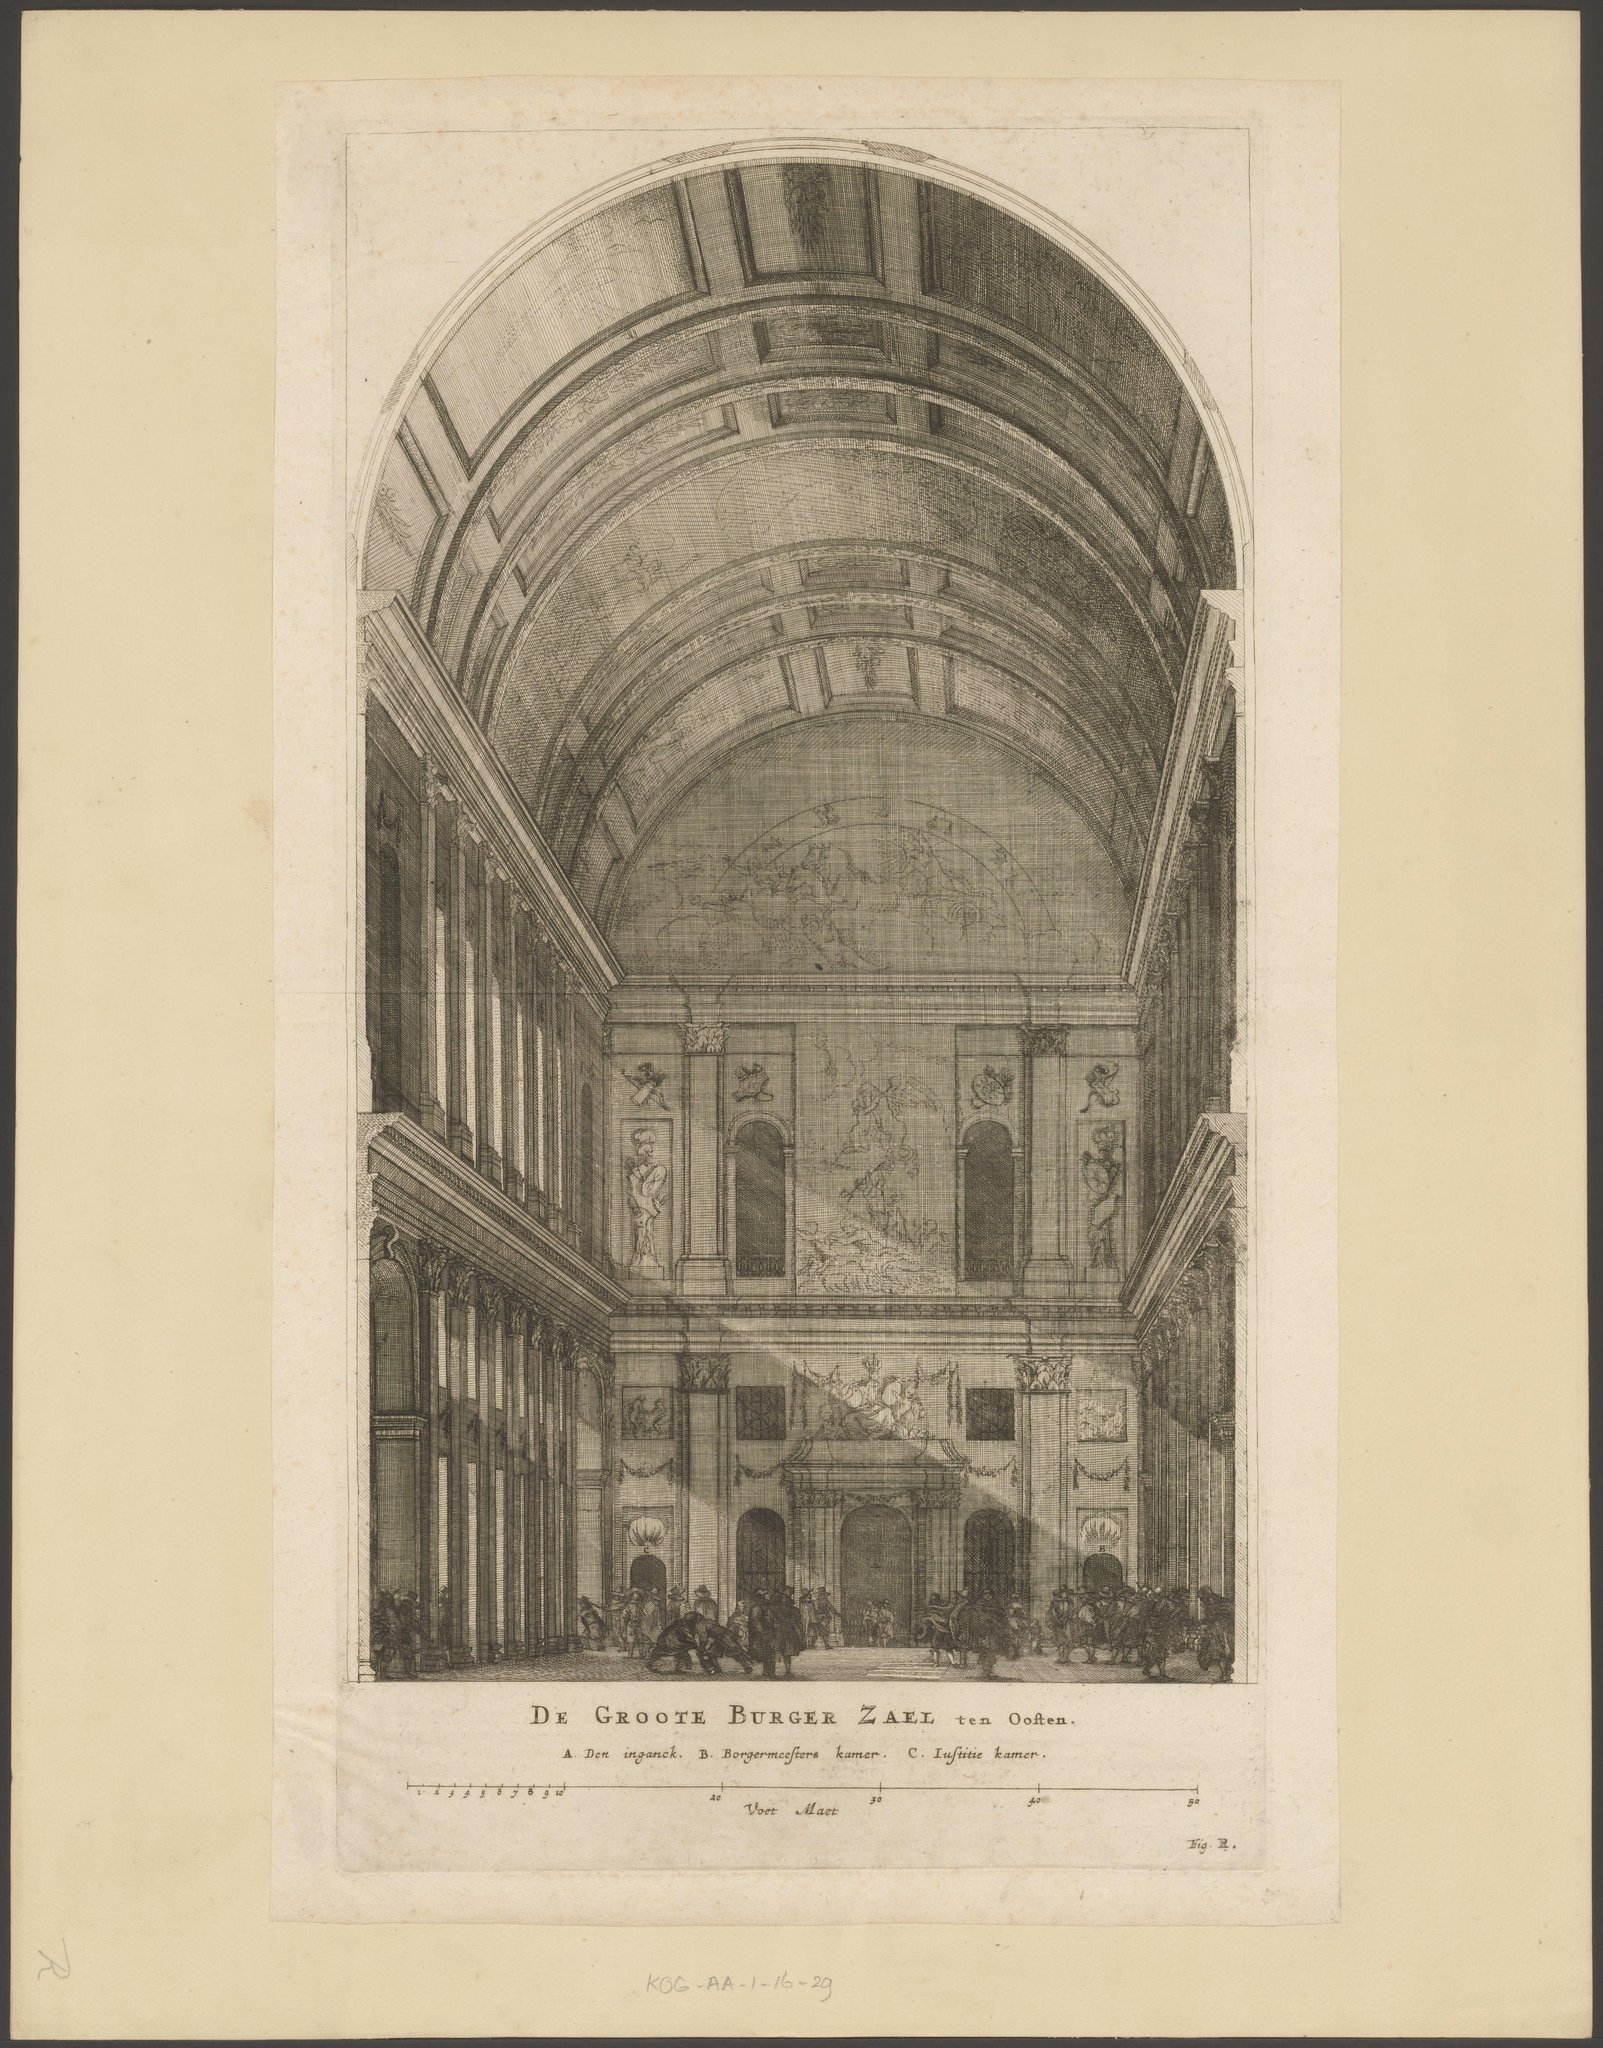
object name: print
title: Oostzijde van de Burgerzaal in het Stadhuis op de Dam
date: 1661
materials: paper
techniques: engraving, etching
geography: amsterdam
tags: interior ~ architectural design or model, townhall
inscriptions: collector's mark: ‘16,29’ Lugt 1641b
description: Onderwerpsrubriek binnen de Atlas Amsterdam: Stadhuis op de Dam. Rechtsonder: Fig. R.